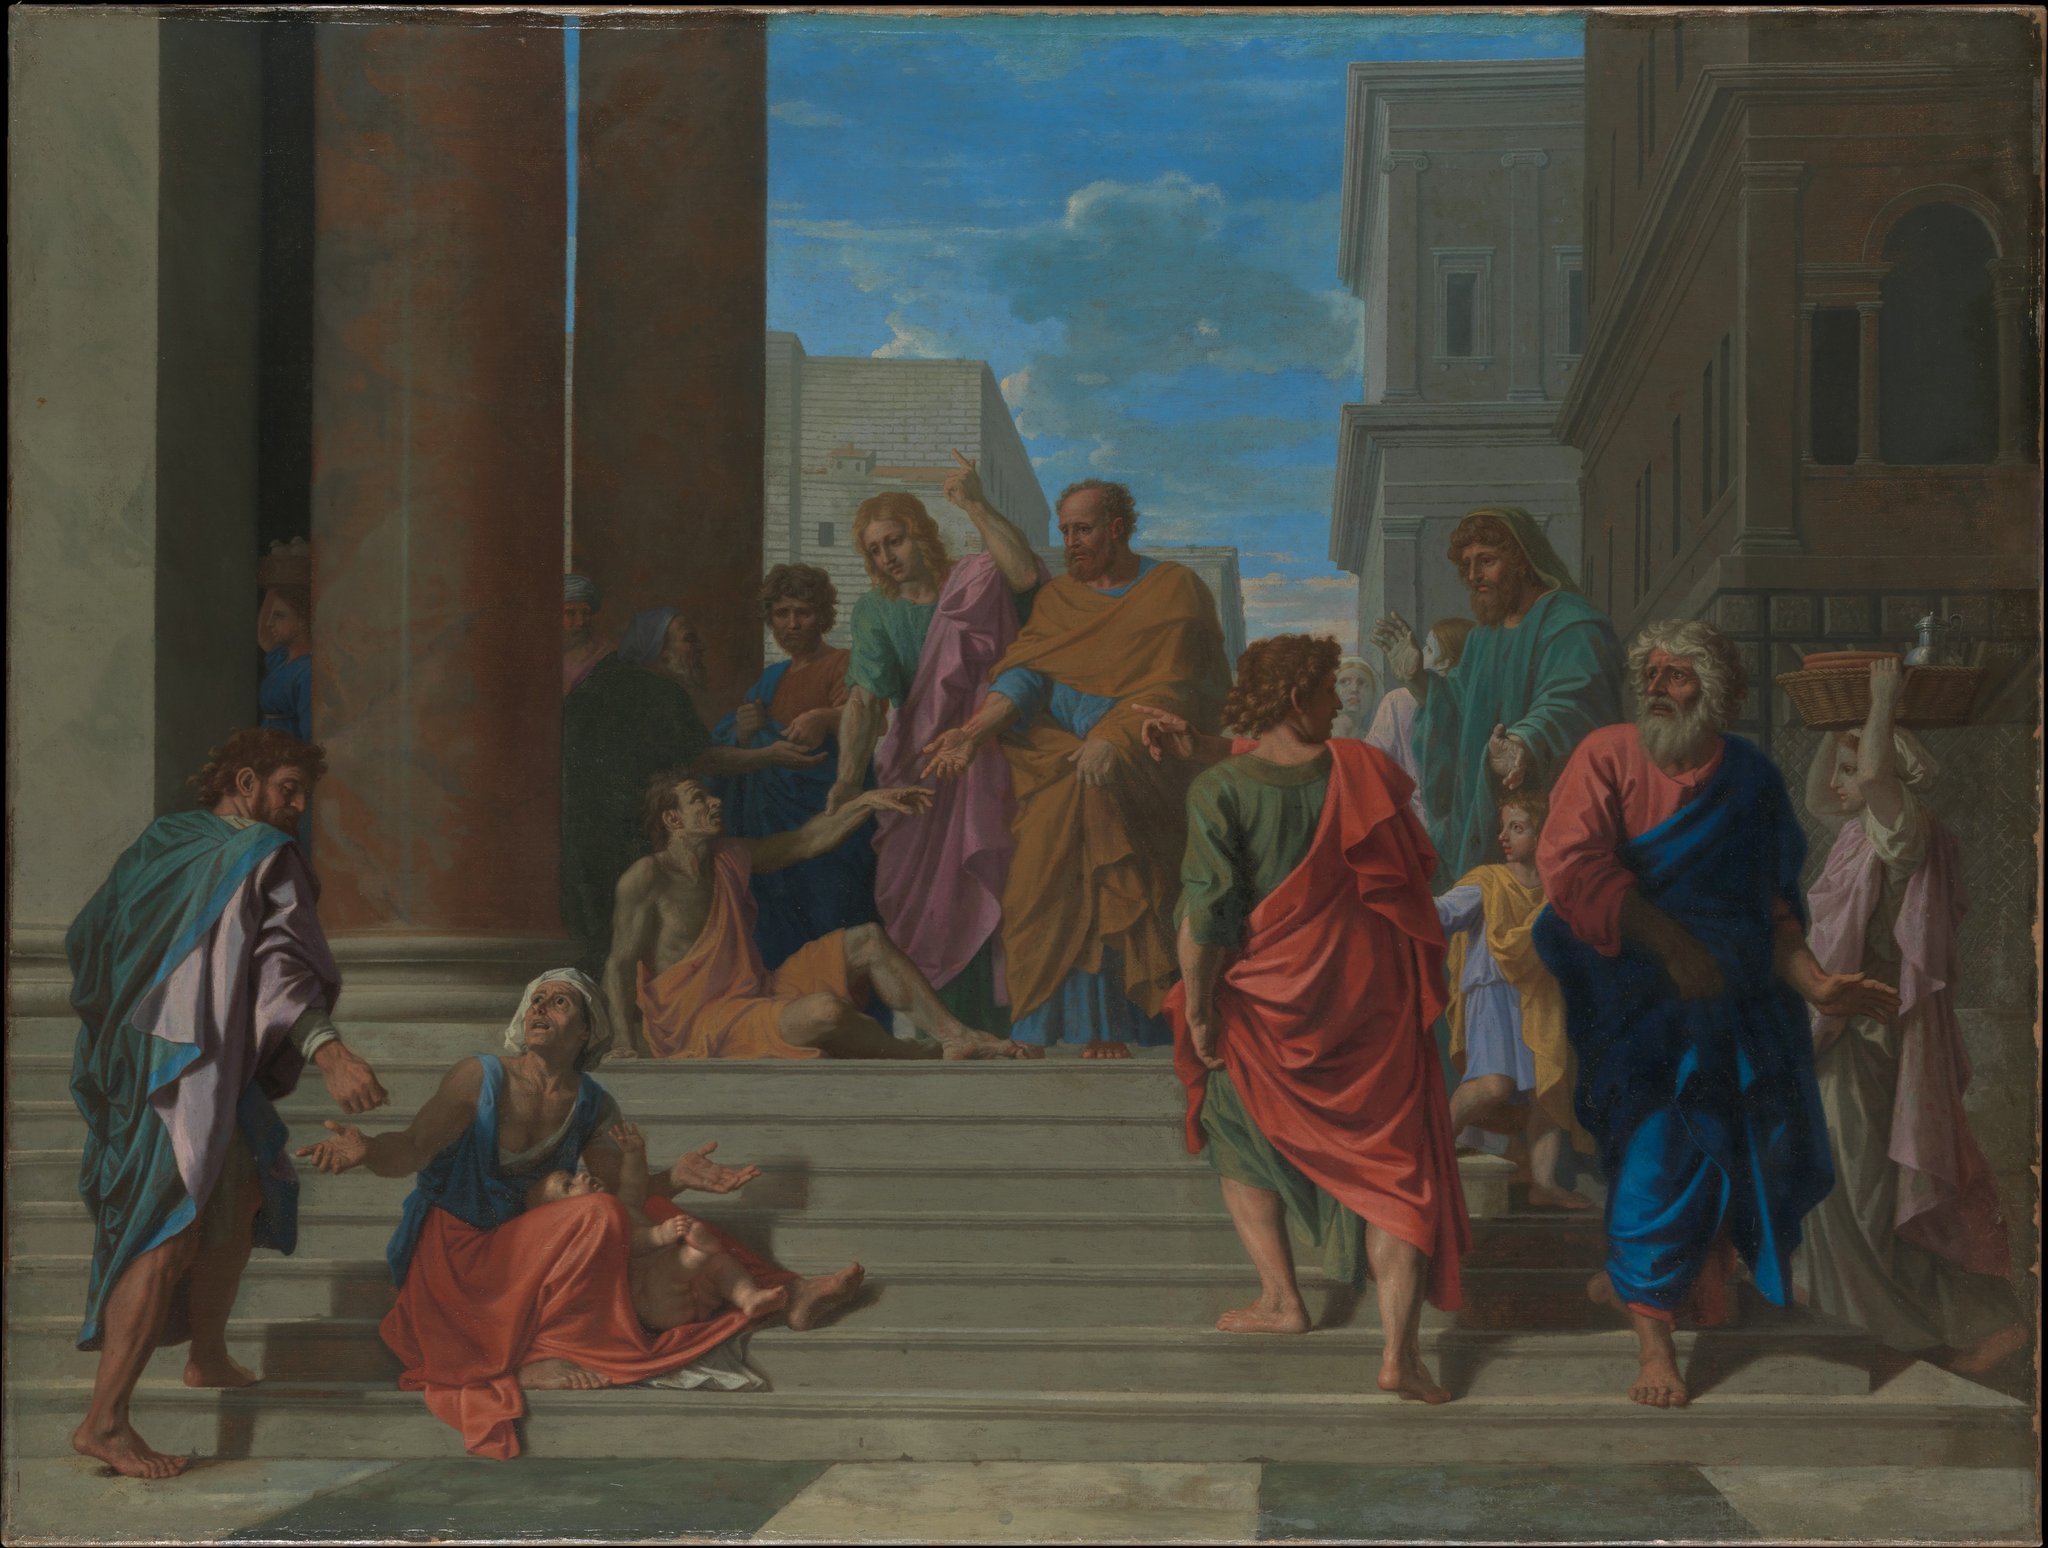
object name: painting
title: Saints Peter and John Healing the Lame Man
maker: nicolas poussin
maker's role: artist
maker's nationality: french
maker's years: 1594-1665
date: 1655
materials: canvas, oil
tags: men,saint john the evangelist,saint peter